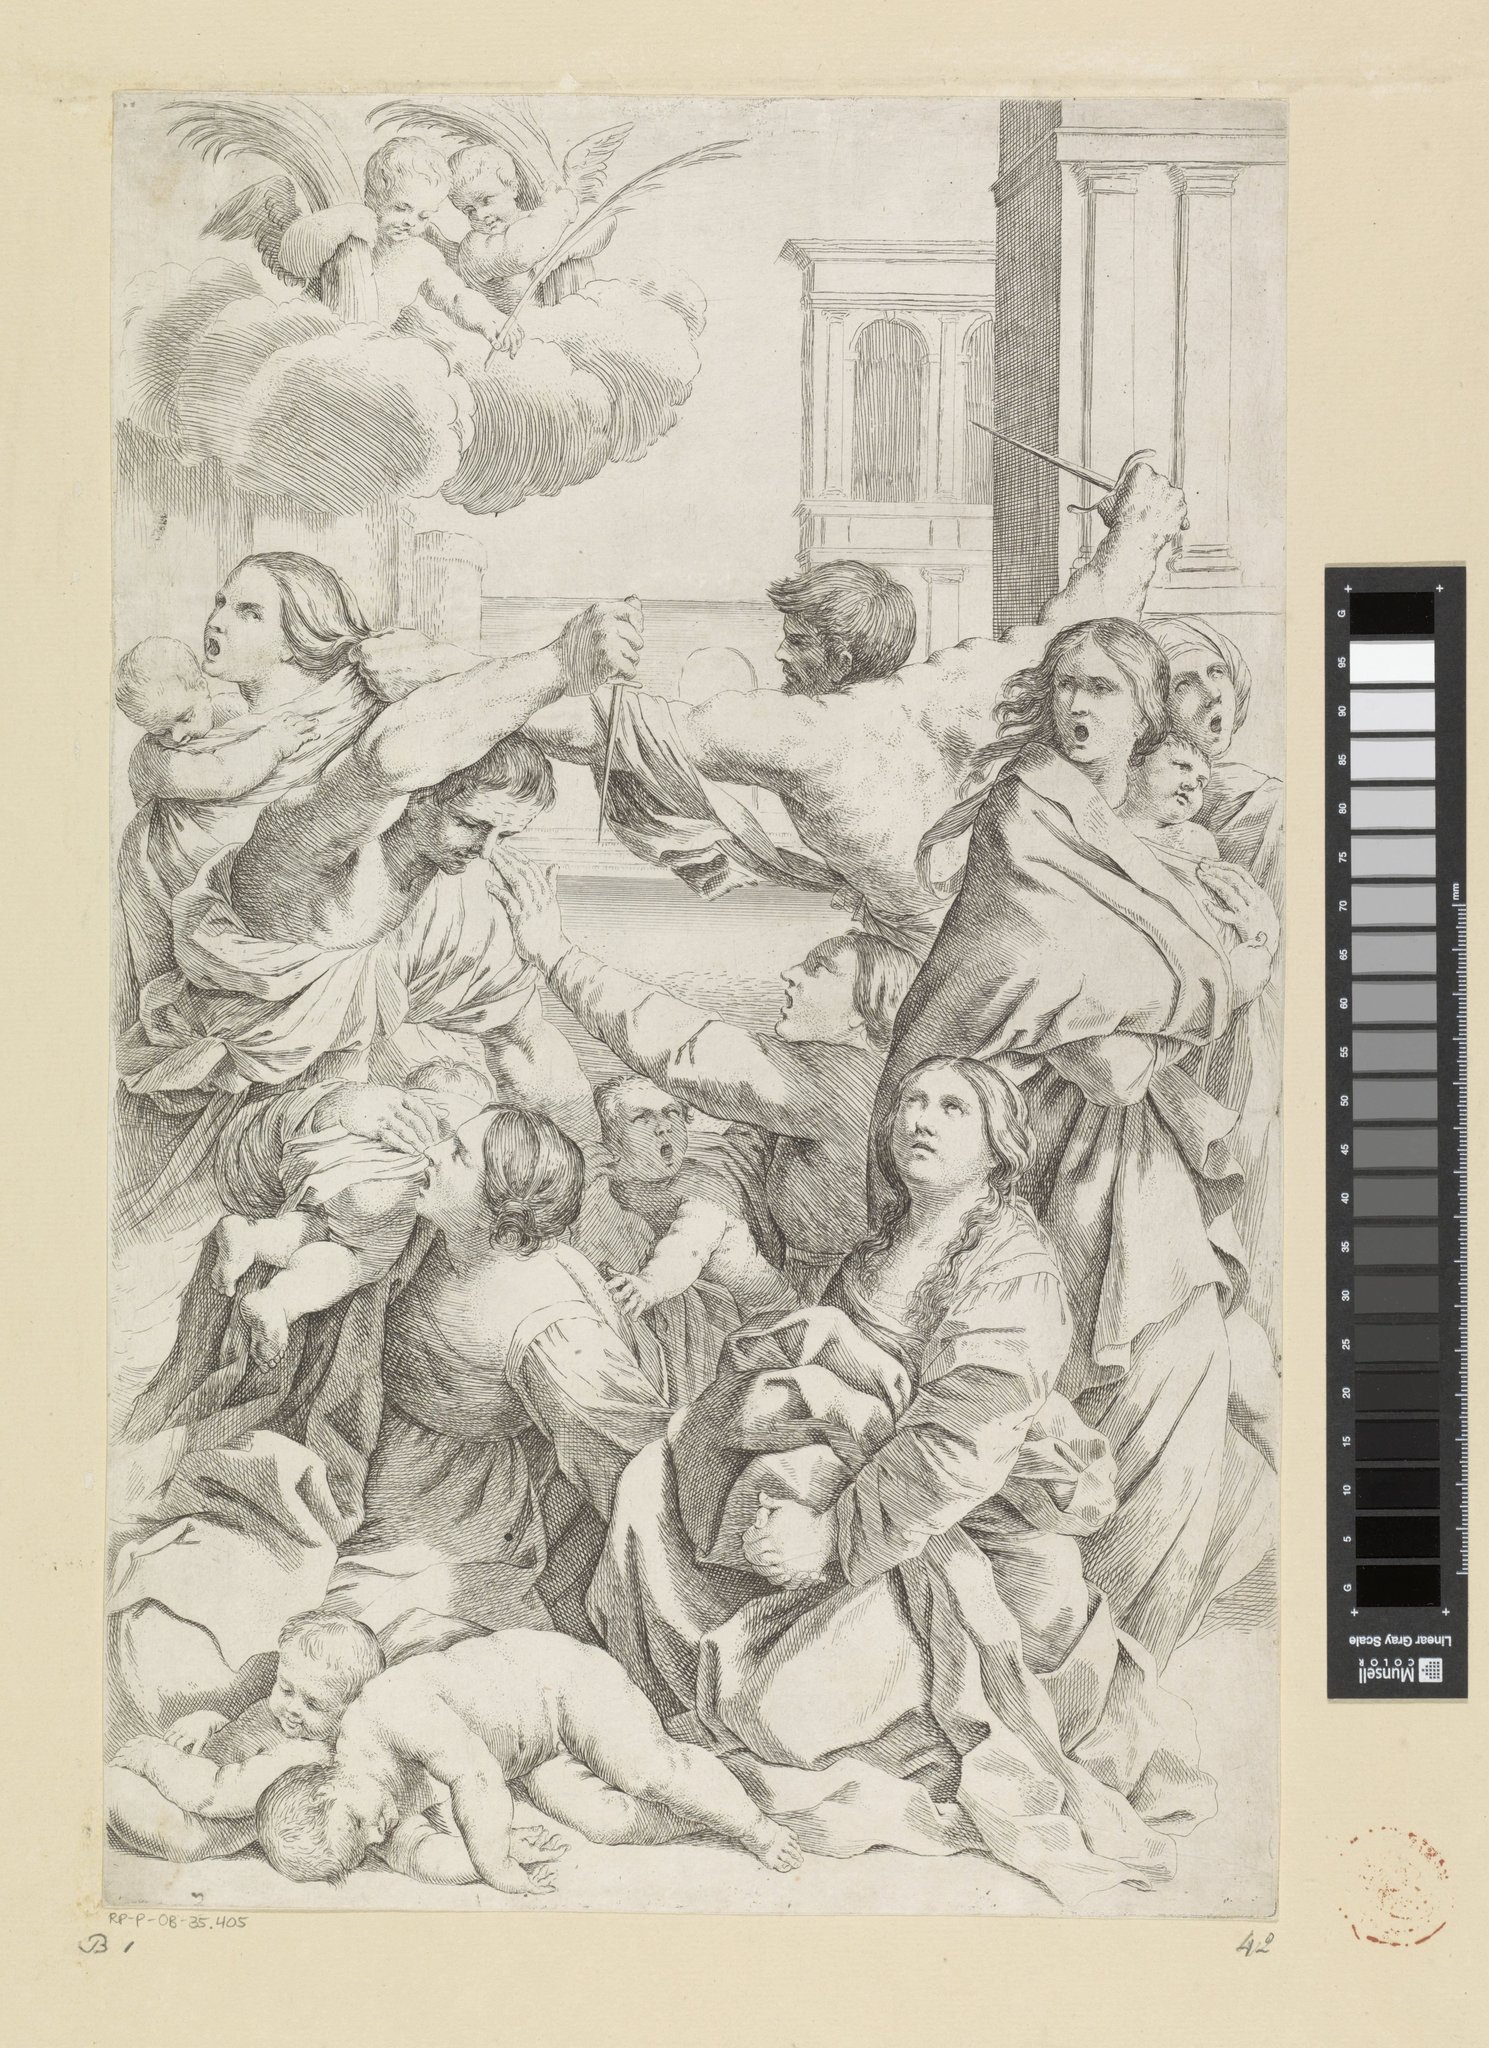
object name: print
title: Kindermoord te Betlehem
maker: gian battista bolognini (i)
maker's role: print maker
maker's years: 1611-1688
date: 1621-1688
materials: paper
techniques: etching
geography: bologna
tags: the massacre ot the innocents; sometimes herod looking on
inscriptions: collector's mark: Lugt 240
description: Wanhopige moeders proberen hun kinderen te beschermen tegen de soldaten van Herodes. Op de achtergrond gebouwen. Linksboven twee putti met bossen palmtakken op wolken.